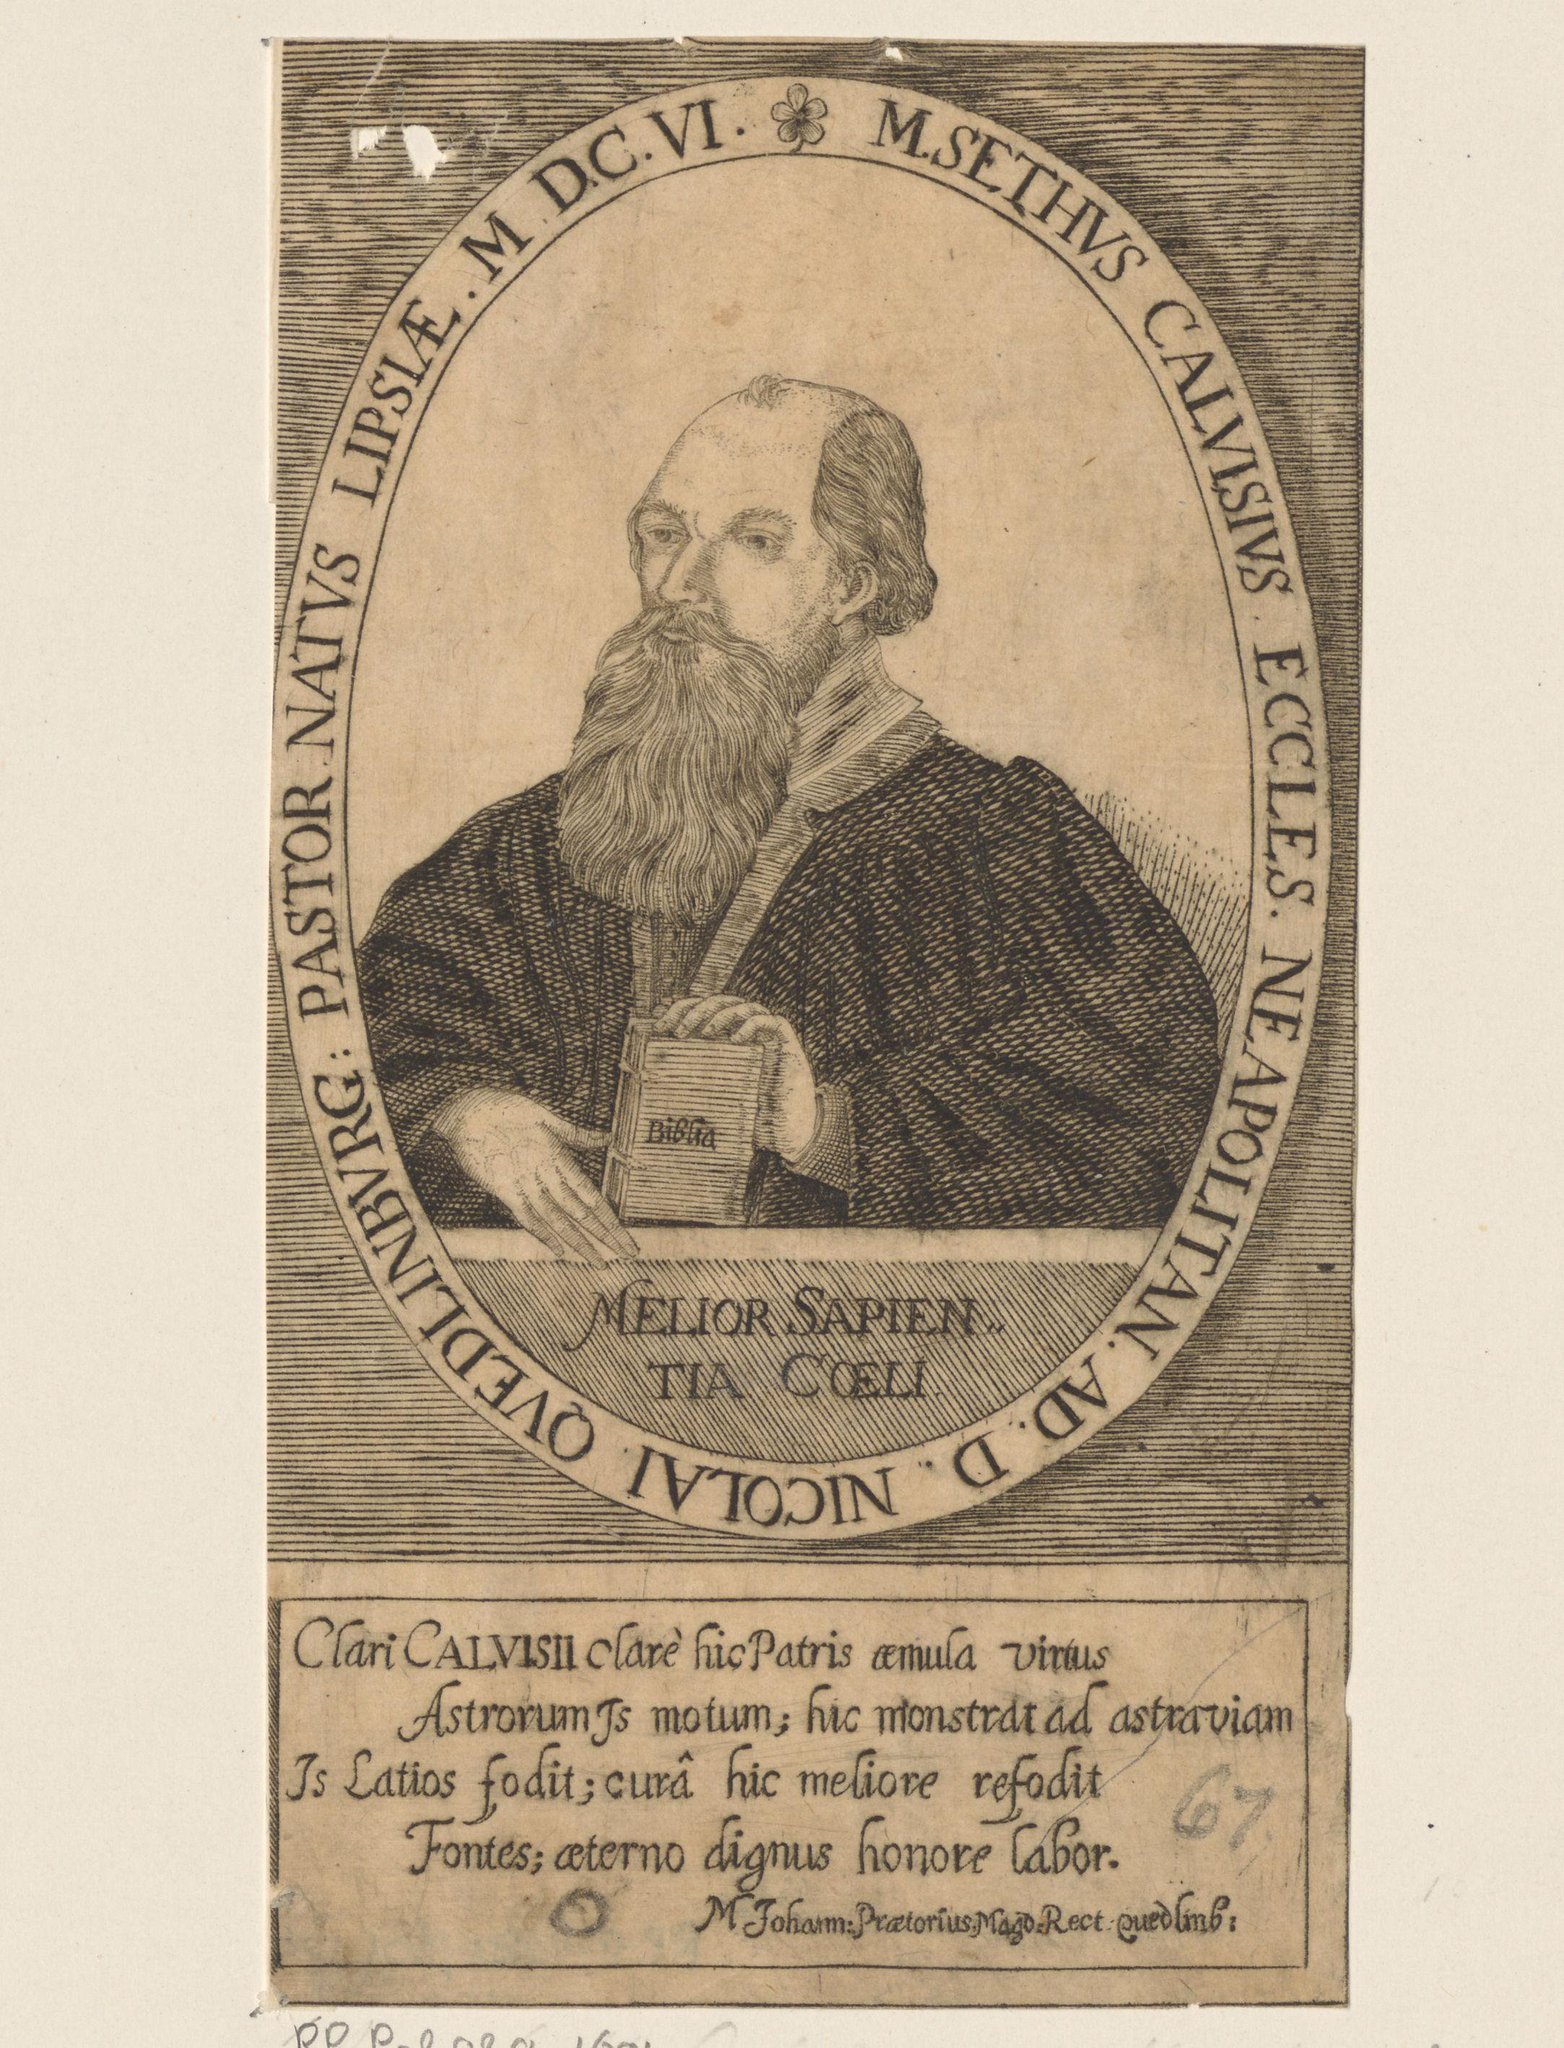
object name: print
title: Portret van Sethus Calvisius II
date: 1651-1699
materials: paper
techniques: engraving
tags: historical persons